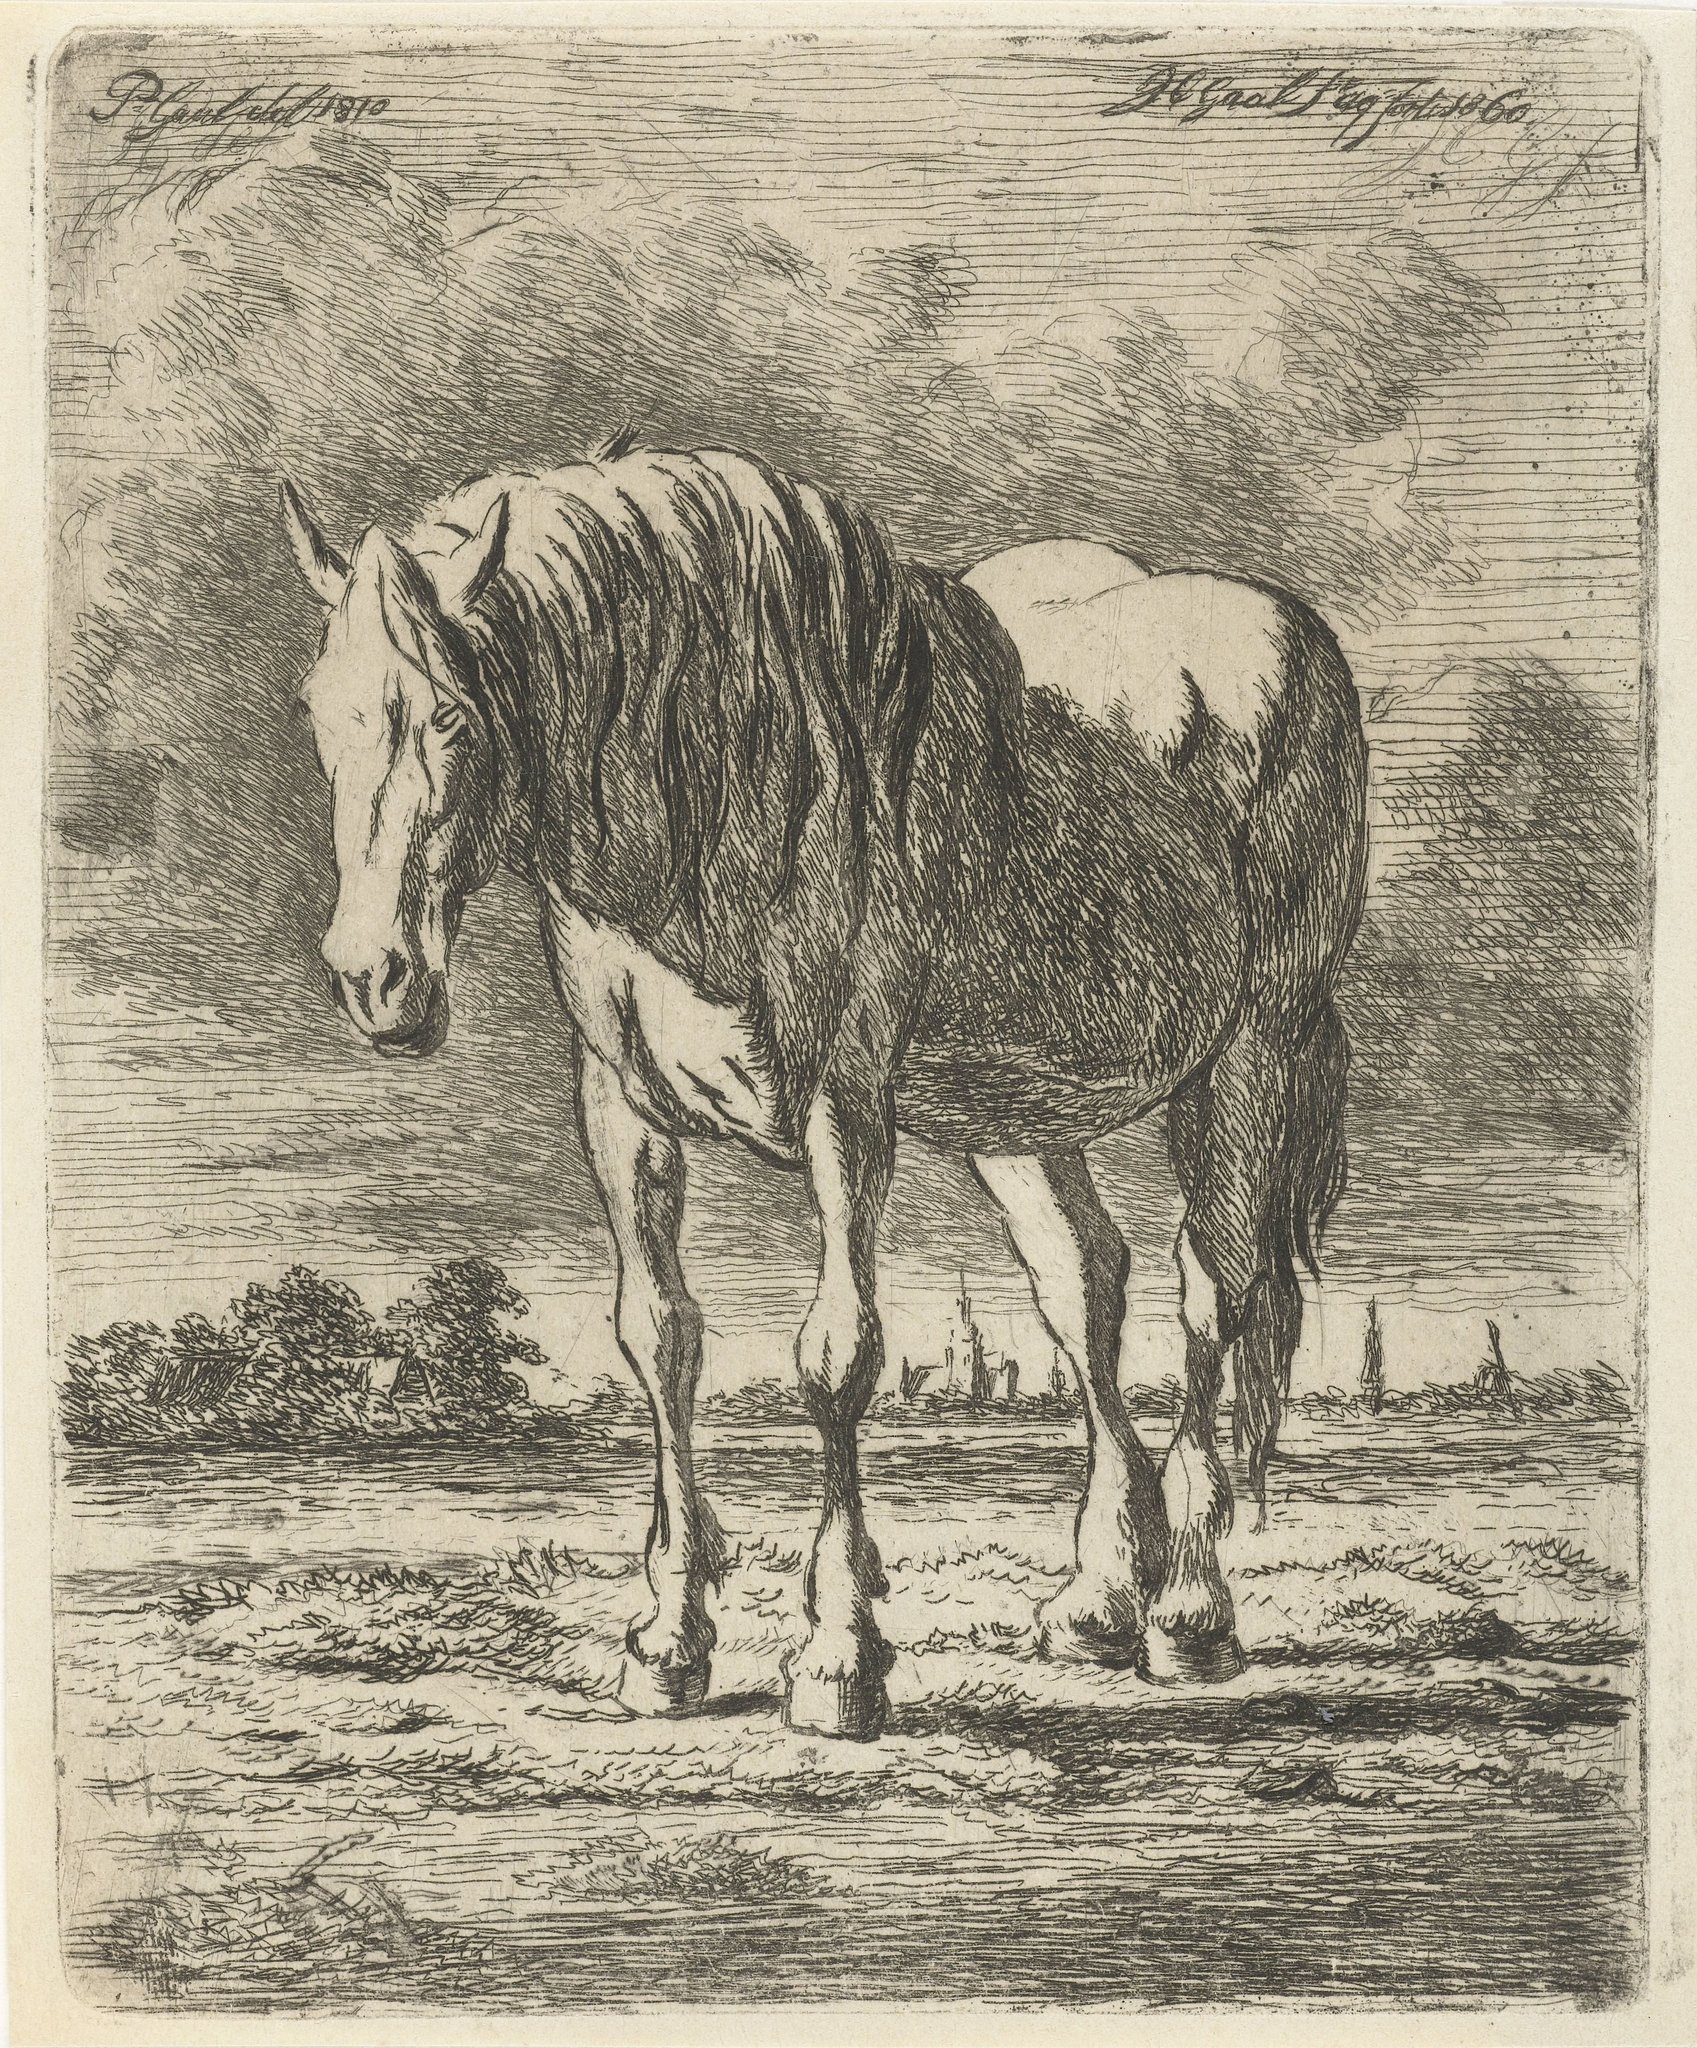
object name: print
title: Staand wit paard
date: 1860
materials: paper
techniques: etching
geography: netherlands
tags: horses and kindred animals, horse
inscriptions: collector's mark: Lugt 2228